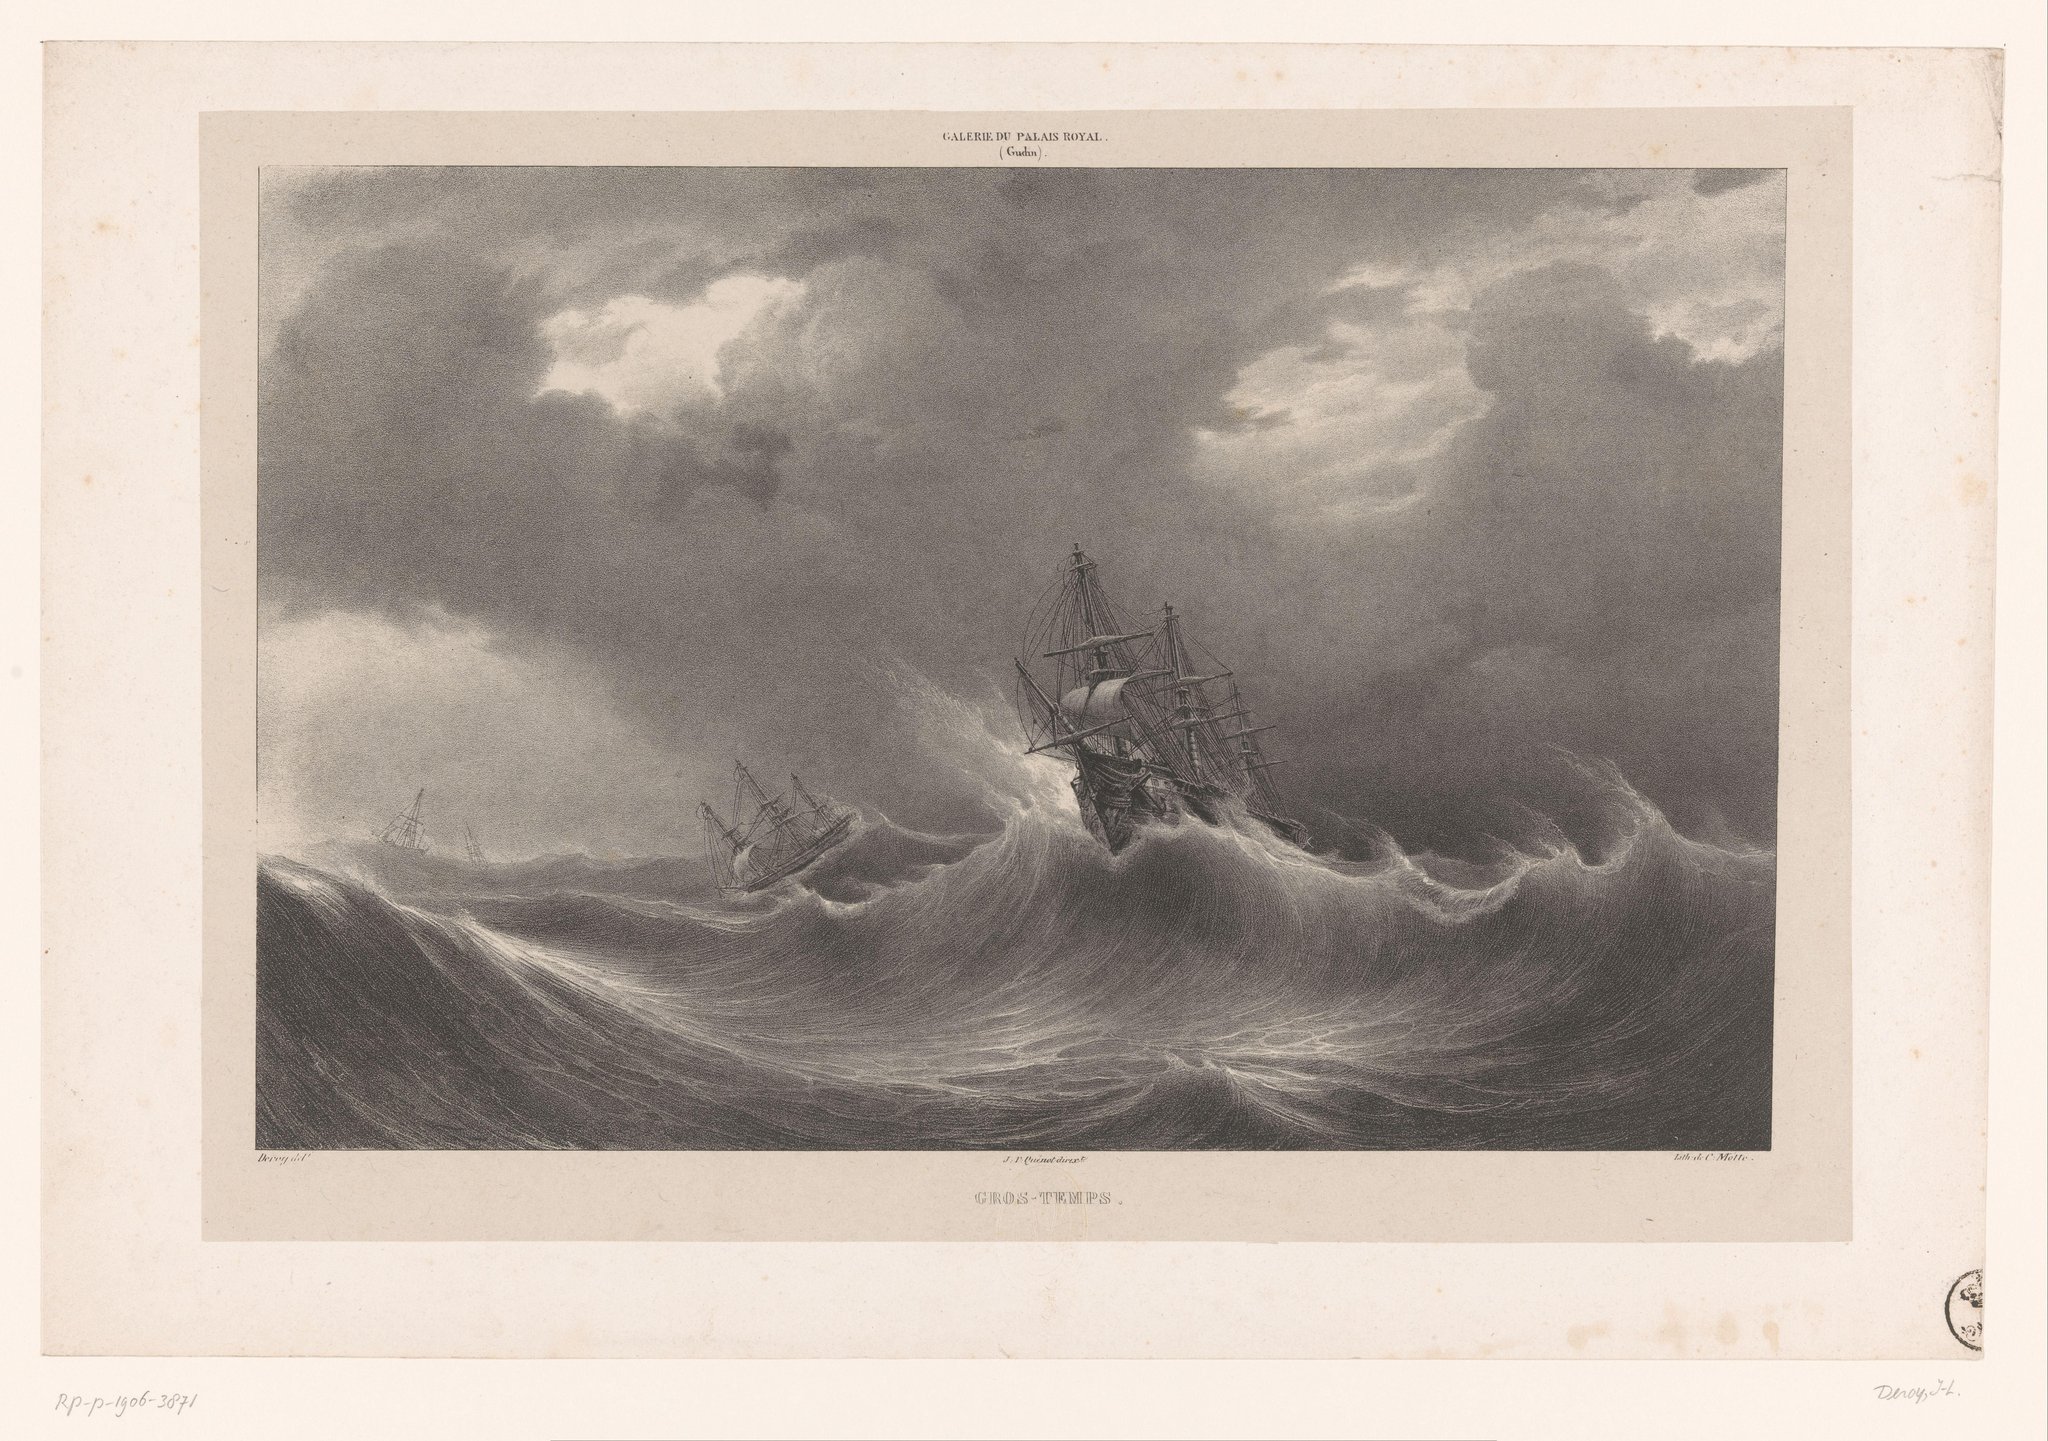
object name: print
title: Gros-Temps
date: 1828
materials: paper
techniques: lithograph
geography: paris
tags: sea (seascape), ships (in general) - cc - more than one ship, storm at sea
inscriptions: collector's mark: Lugt 2228a, check stamp: Lugt 1999d